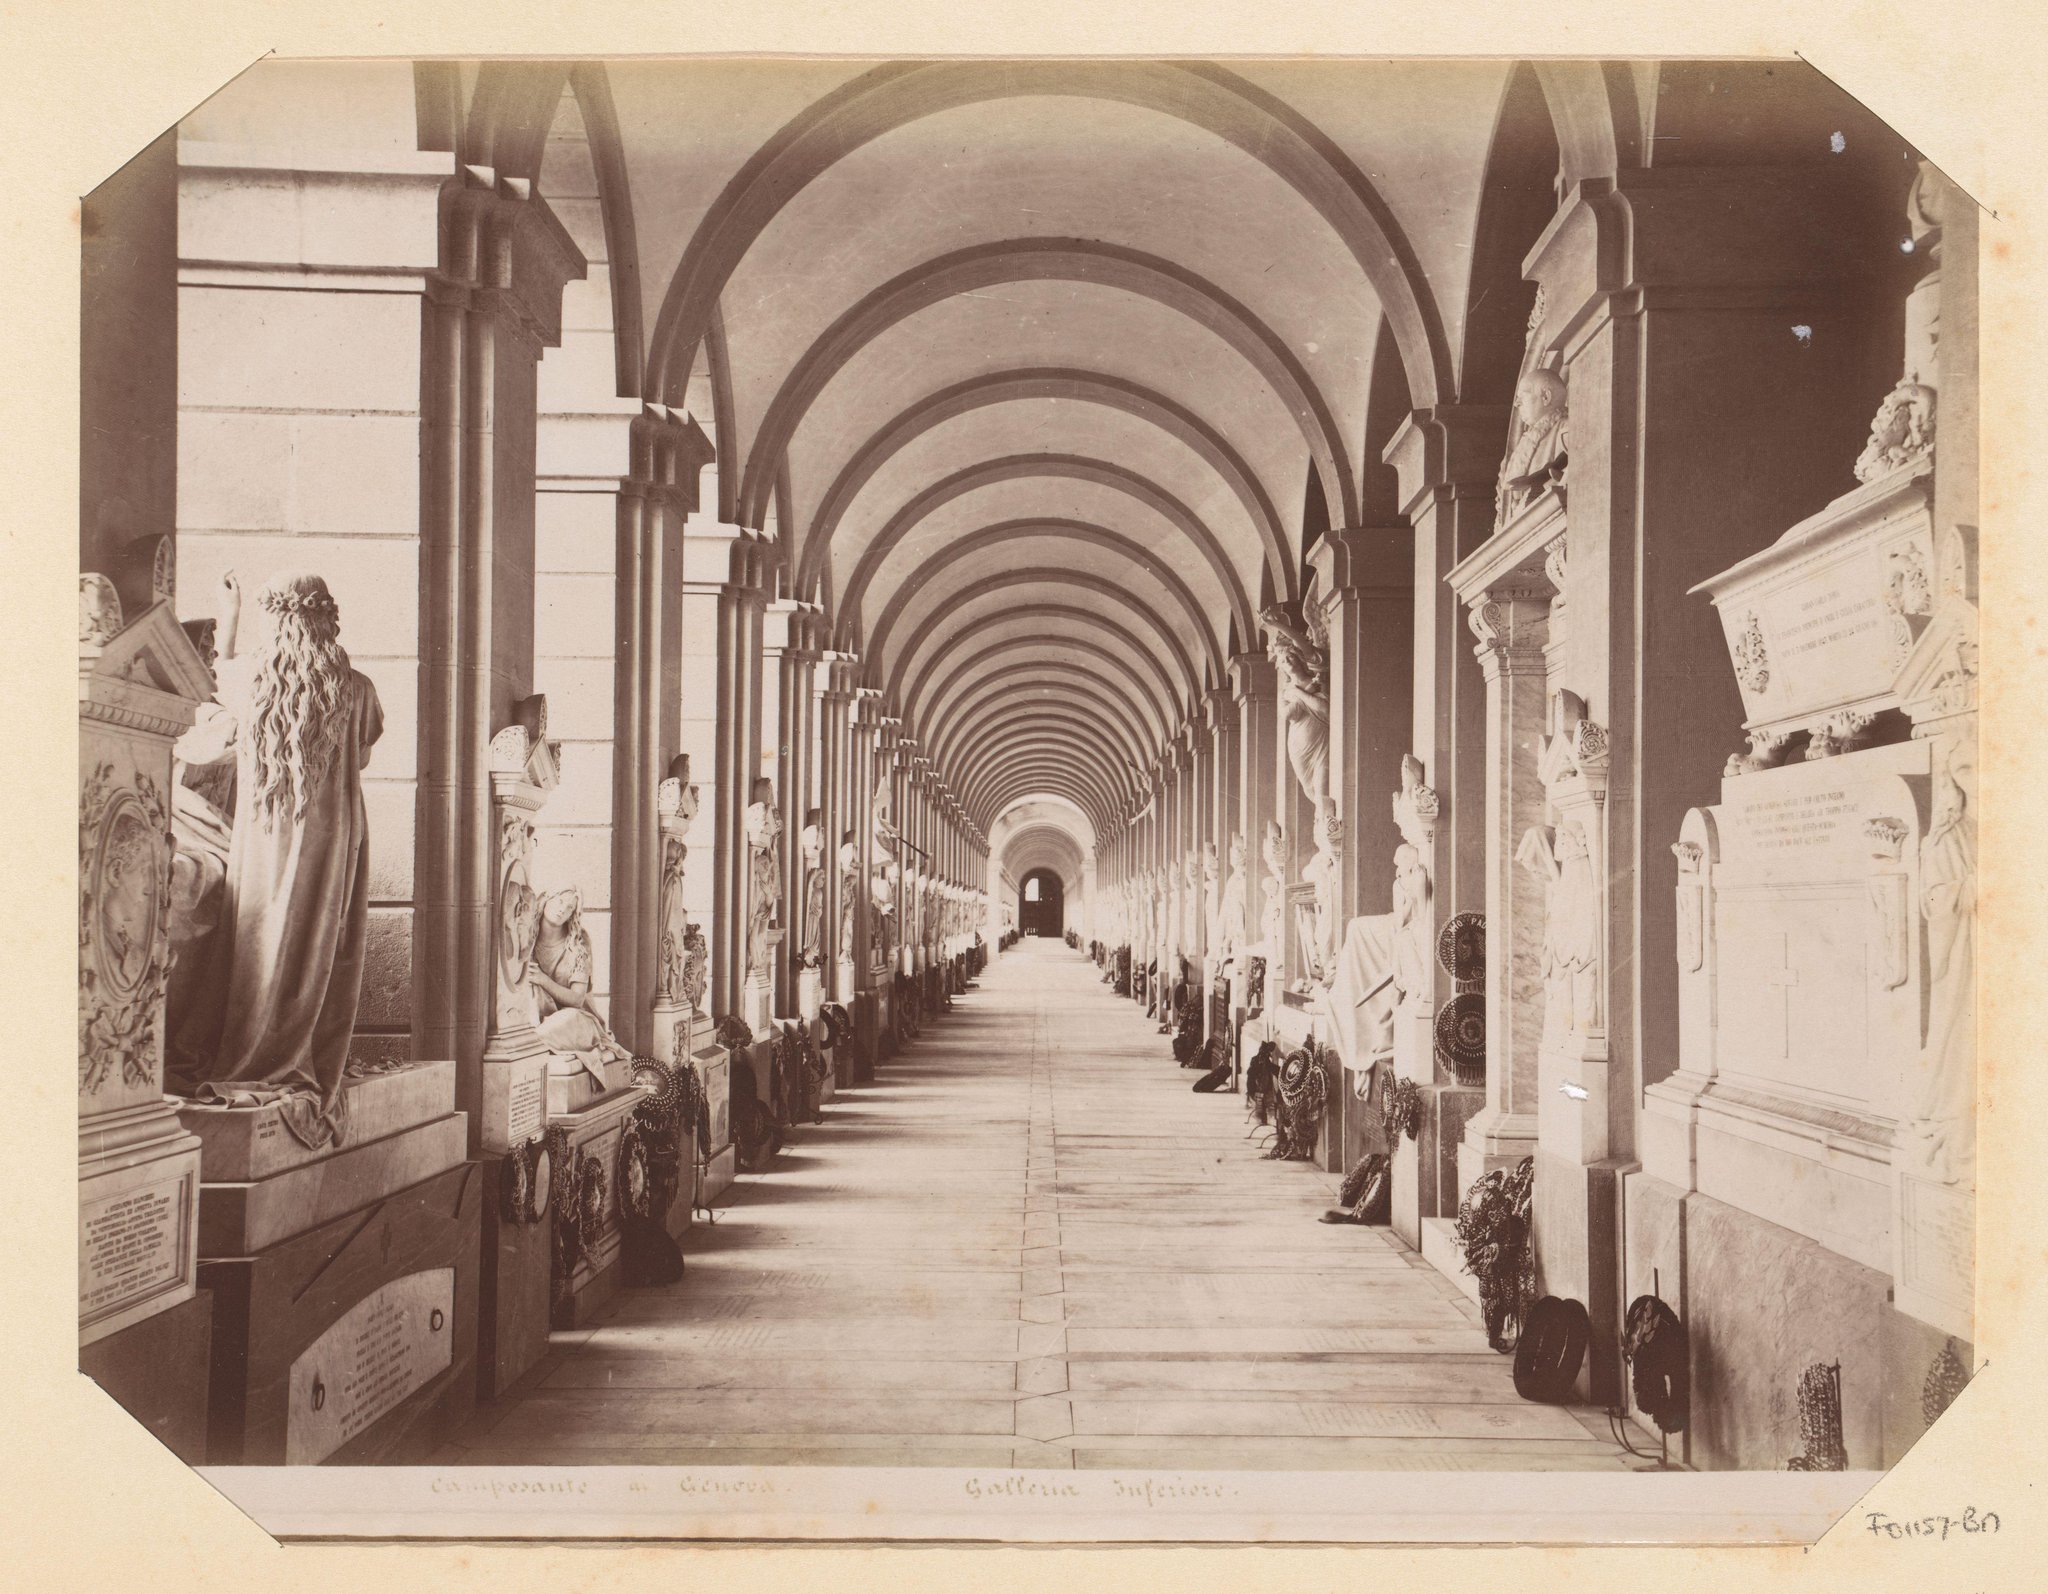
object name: photograph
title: Zuilengalerij bij de begraafplaats Staglieno te Genua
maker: Anonymous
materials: photographic support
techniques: albumen print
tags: colonnade, cemetery, park-like burying ground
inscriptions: annotation: ‘Genua - Camposanto’